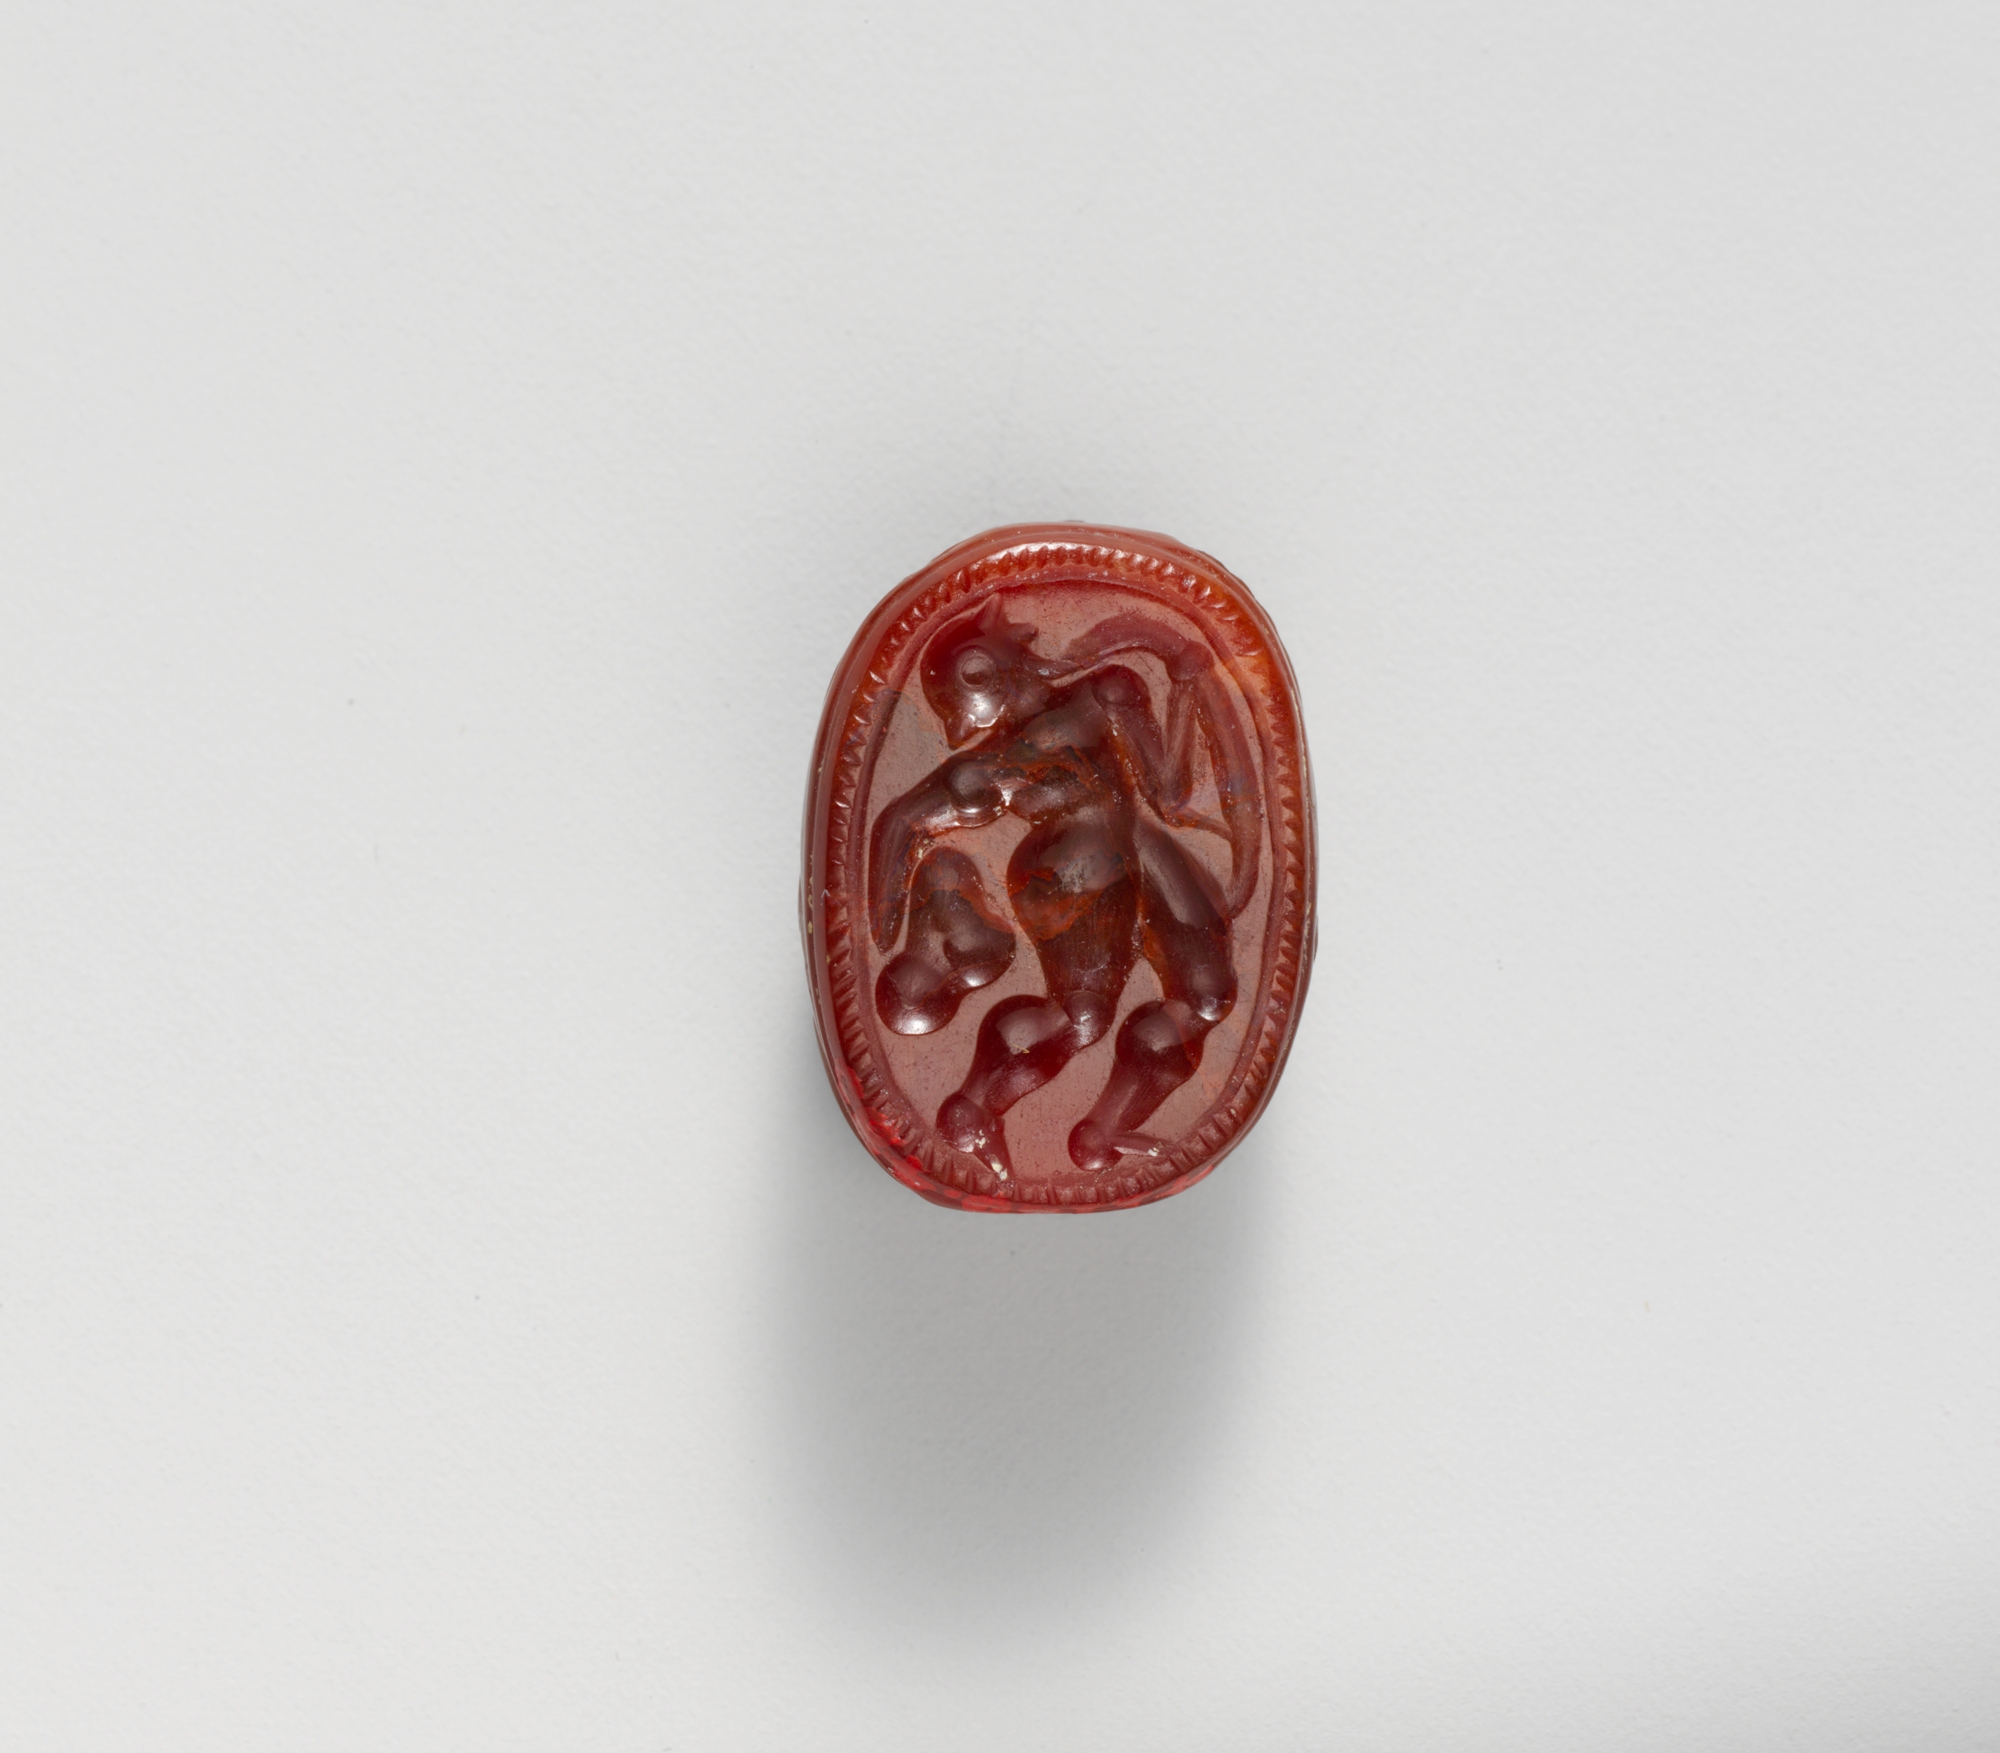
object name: scarab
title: Carnelian scarab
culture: etruscan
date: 325-200 BCE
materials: gemstone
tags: warriors